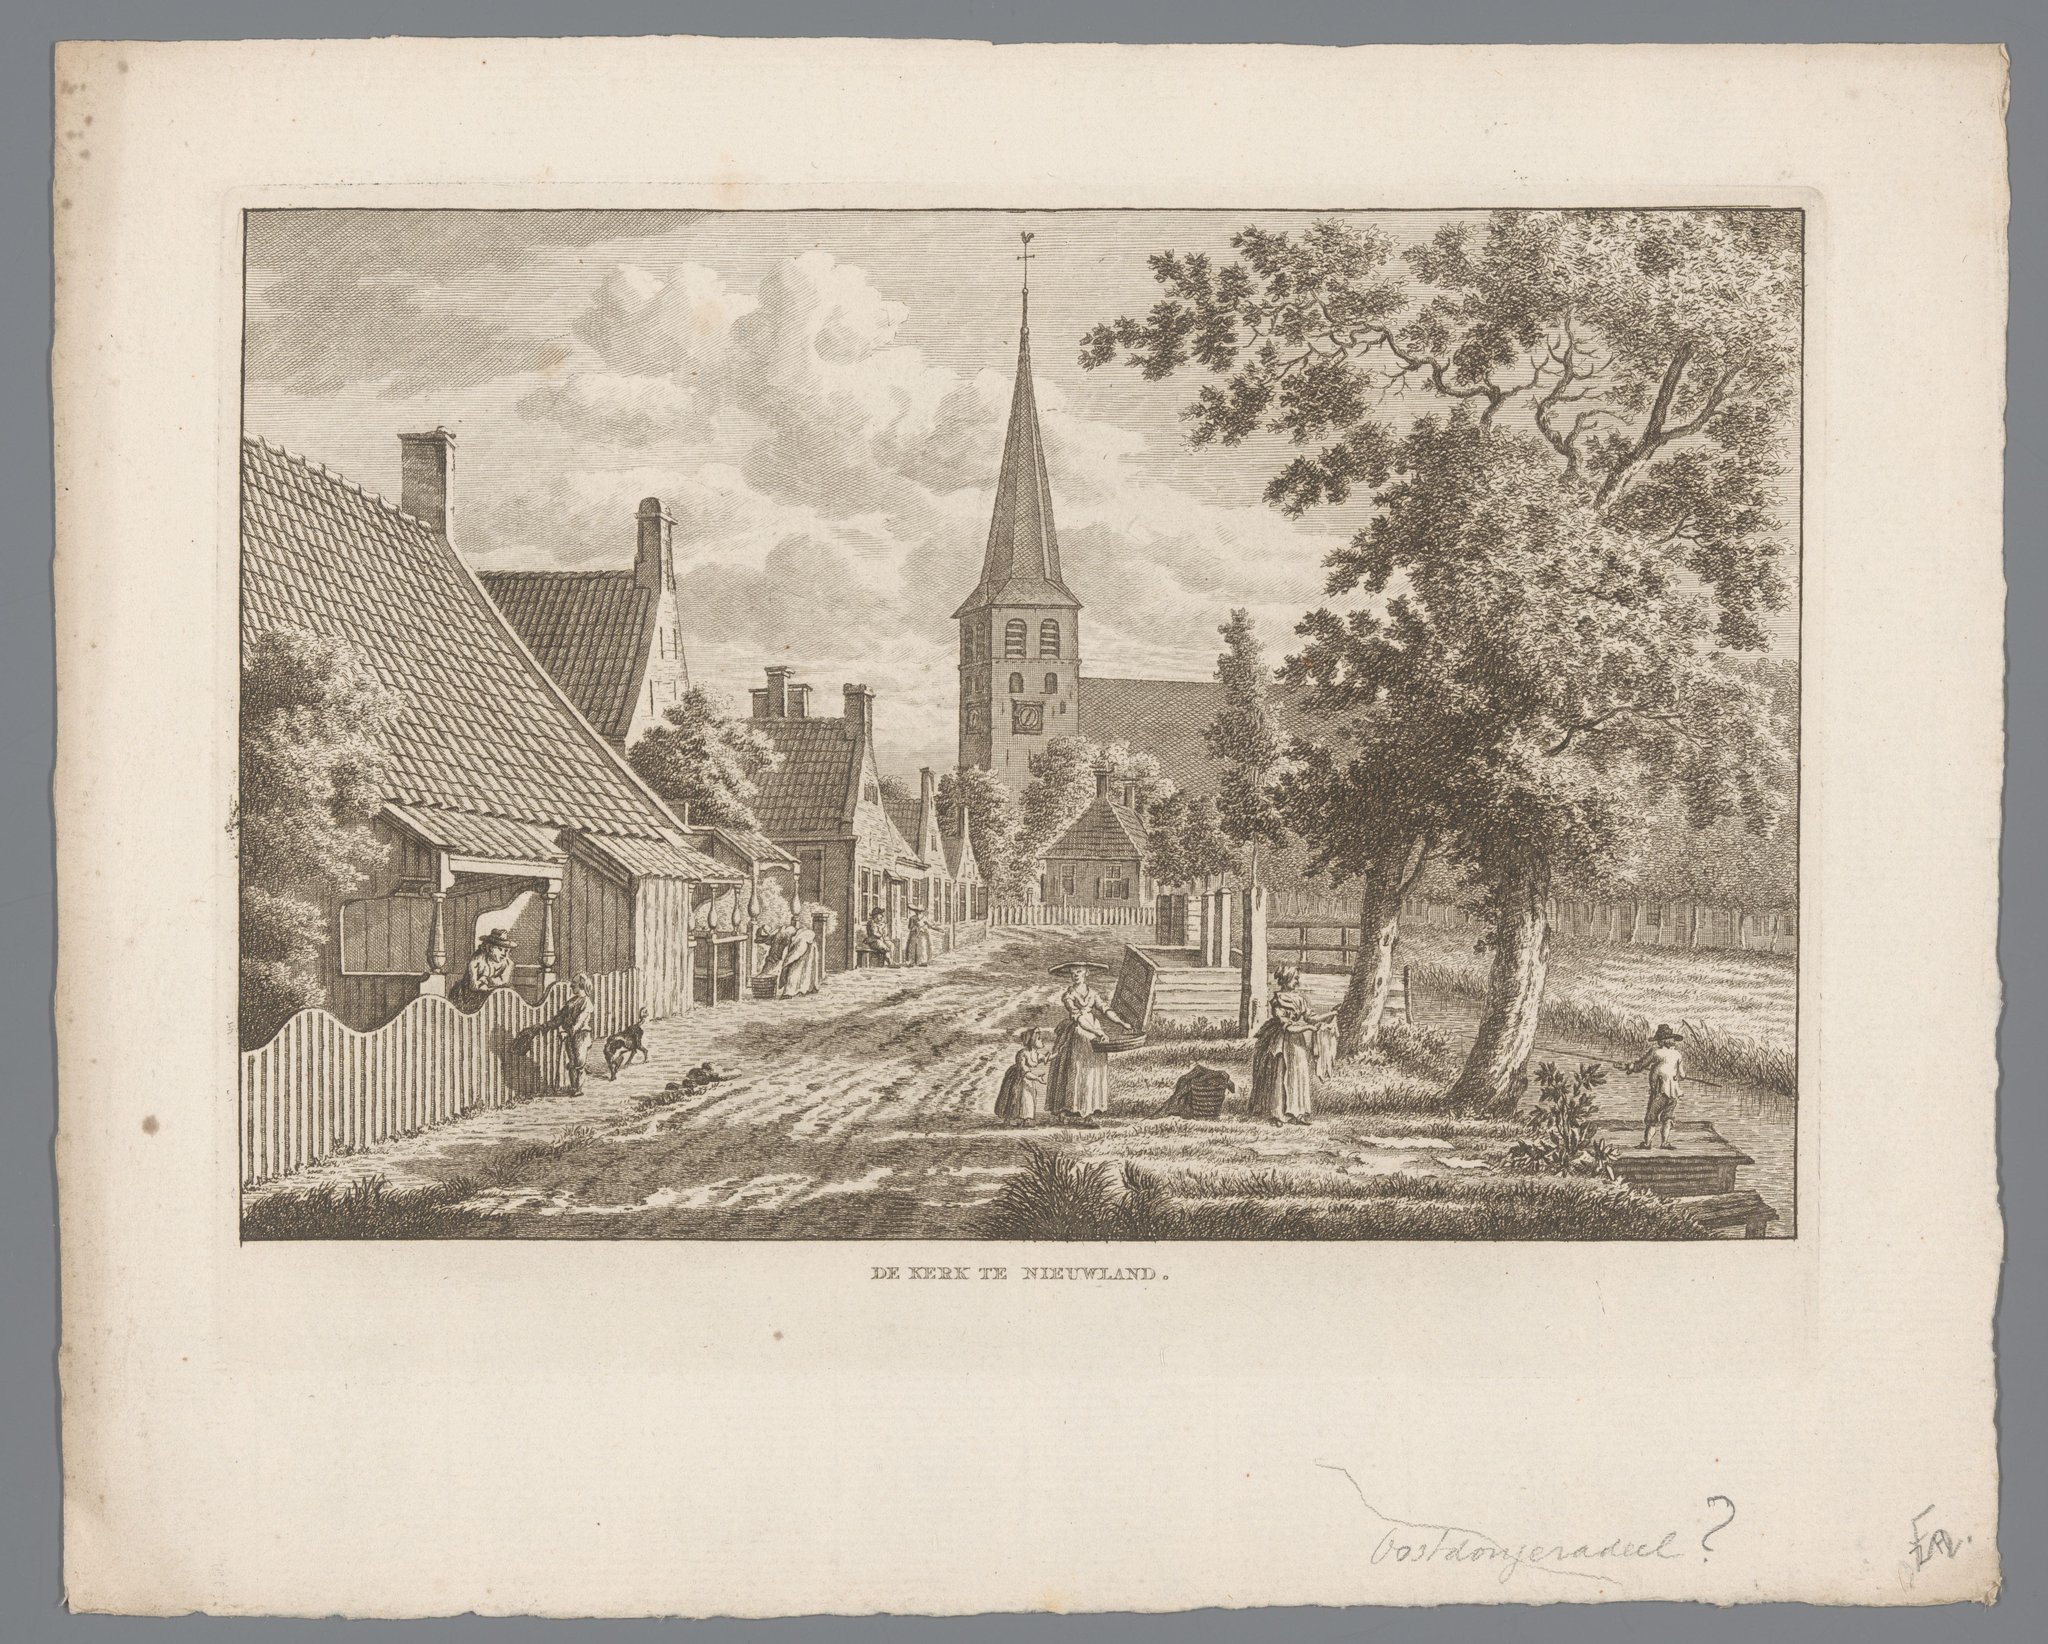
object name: print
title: De kerk te Nieuwland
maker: carel frederik bendorp (i)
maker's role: print maker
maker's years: 1736-1814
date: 1786-1792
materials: paper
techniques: engraving, etching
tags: prospect of village, silhouette of village, church (exterior)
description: Prent uit: Vaderlandsche gezichten, of afbeeldingen van den tegenwoordigen staat der Vereenigde Nederlanden (…). Amsterdam: Hendrik Gartman, Willem Vermandel en Jan Willem Smit, 1786-1792. Uitgegeven in afleveringen met ieder een eigen bifolium en inhoudsopgave. Alle prenten in deze publicatie zijn gegraveerd door Carel Frederik Bendorp (I) en, in de meeste gevallen, gebaseerd op tekeningen van Jan Bulthuis.